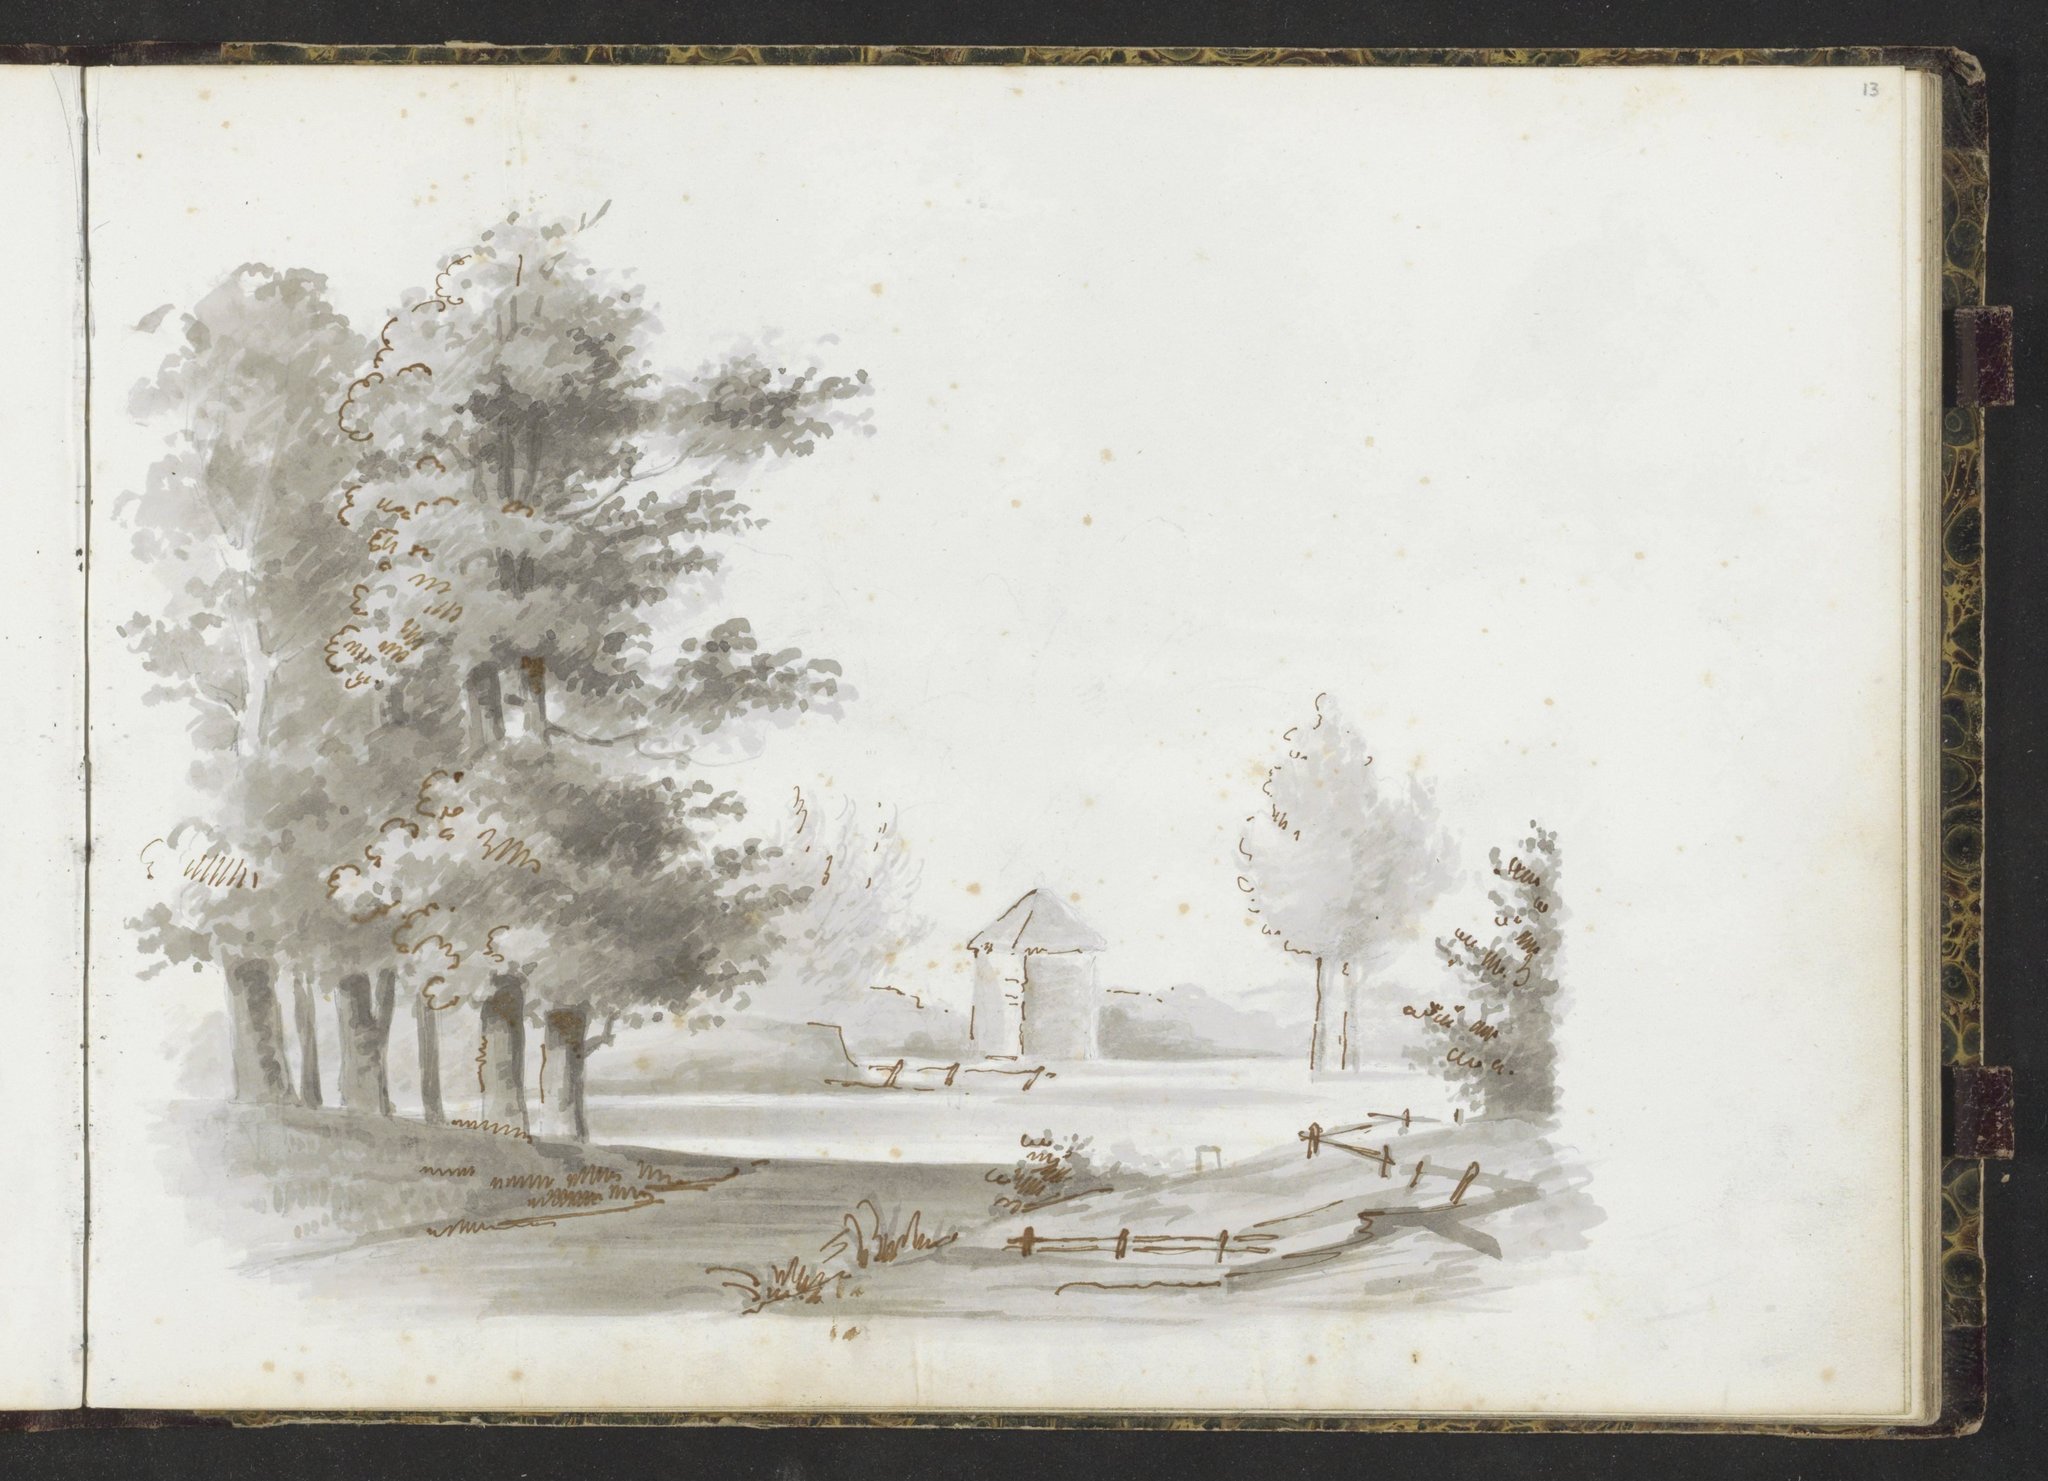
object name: sketchbook leaf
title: Landschap met bomen en een toren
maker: lambertus lingeman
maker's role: draughtsman, painter, print maker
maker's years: 1829-1894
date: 1839-1894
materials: ink, paper, pencil, watercolor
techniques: brush, pen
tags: city-view, and landscape with man-made constructions, trees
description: Blad 13 recto uit een schetsboek met 51 bladen.